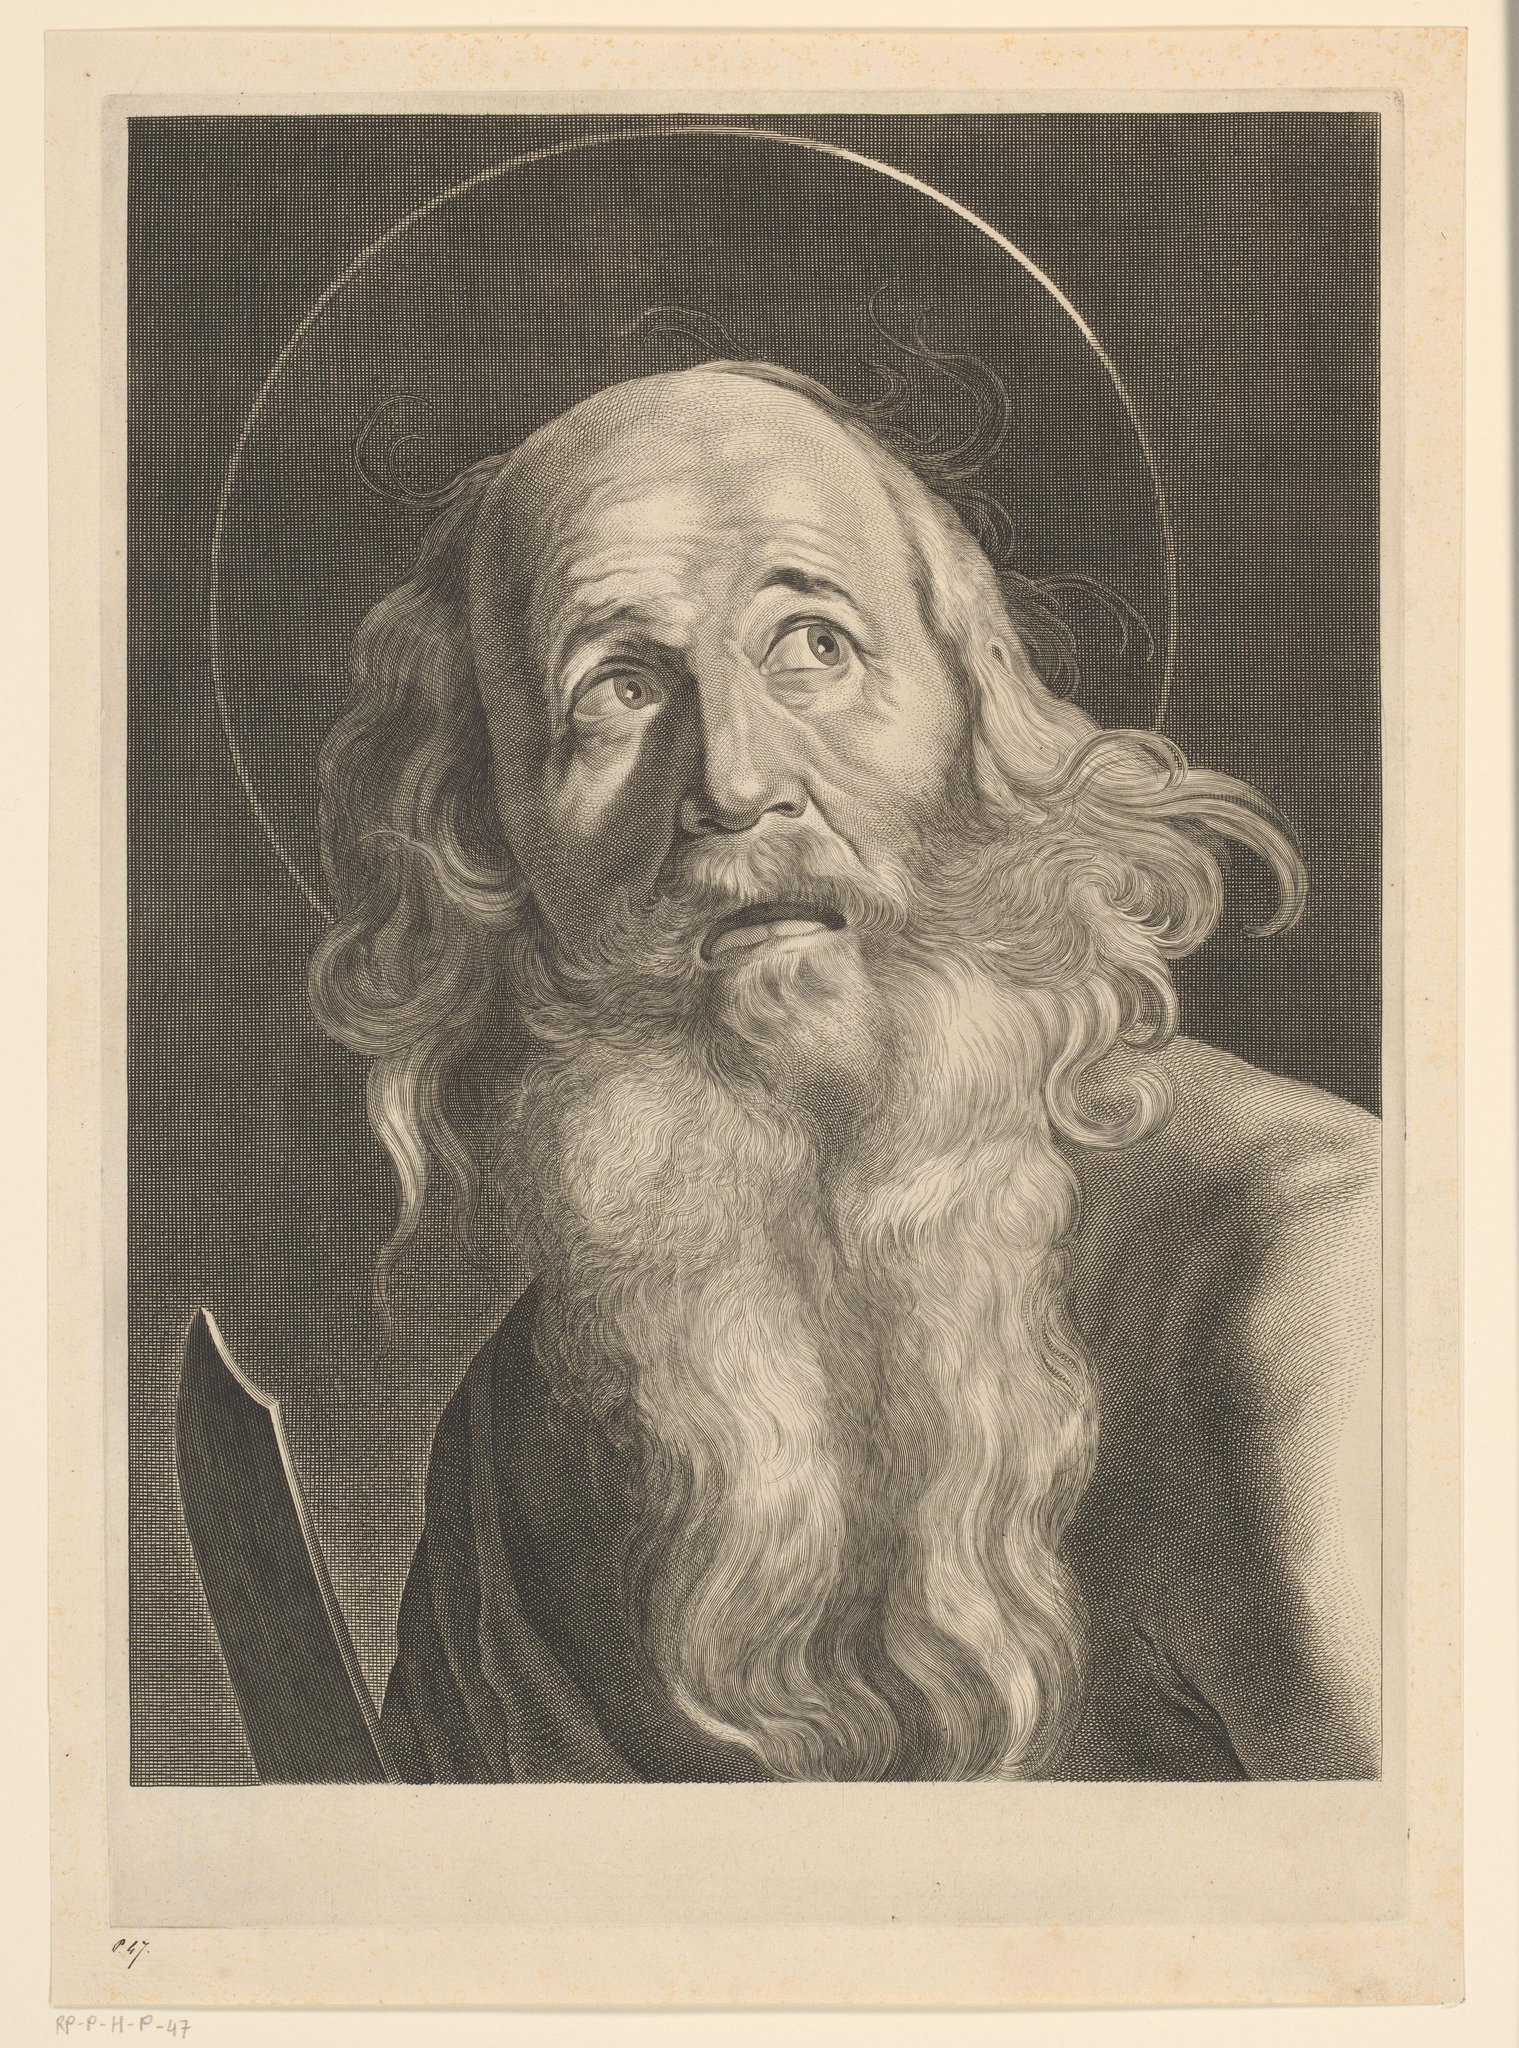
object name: print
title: Caelaturae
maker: theodor matham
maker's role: draughtsman, print maker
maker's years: 1605-1676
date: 1621-1676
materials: paper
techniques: engraving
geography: amsterdam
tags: the apostle bartholomew; possible attributes: book, devil or dragon at feet, knife, scroll, flayed skin, staff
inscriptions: collector's mark: Lugt 11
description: Deze prent maakte ten minste tot 1979 deel uit van een prentalbum met de titel: 't Cabinet der Italiaense schilderije antique statue en borstbeelde van de heer Renst 145 stucks. Simon Schijnvoet heeft in 1709 aan dit album het Schijnvoet-nummer 22, liber nummer 20 toegekend. Prent uit serie Caelaturae met vierendertig reprodukties naar Italiaanse en Nederlandse schilders, vervaardigd door de allerbeste graveurs in opdracht van de verzamelaar Gerard Reynst.